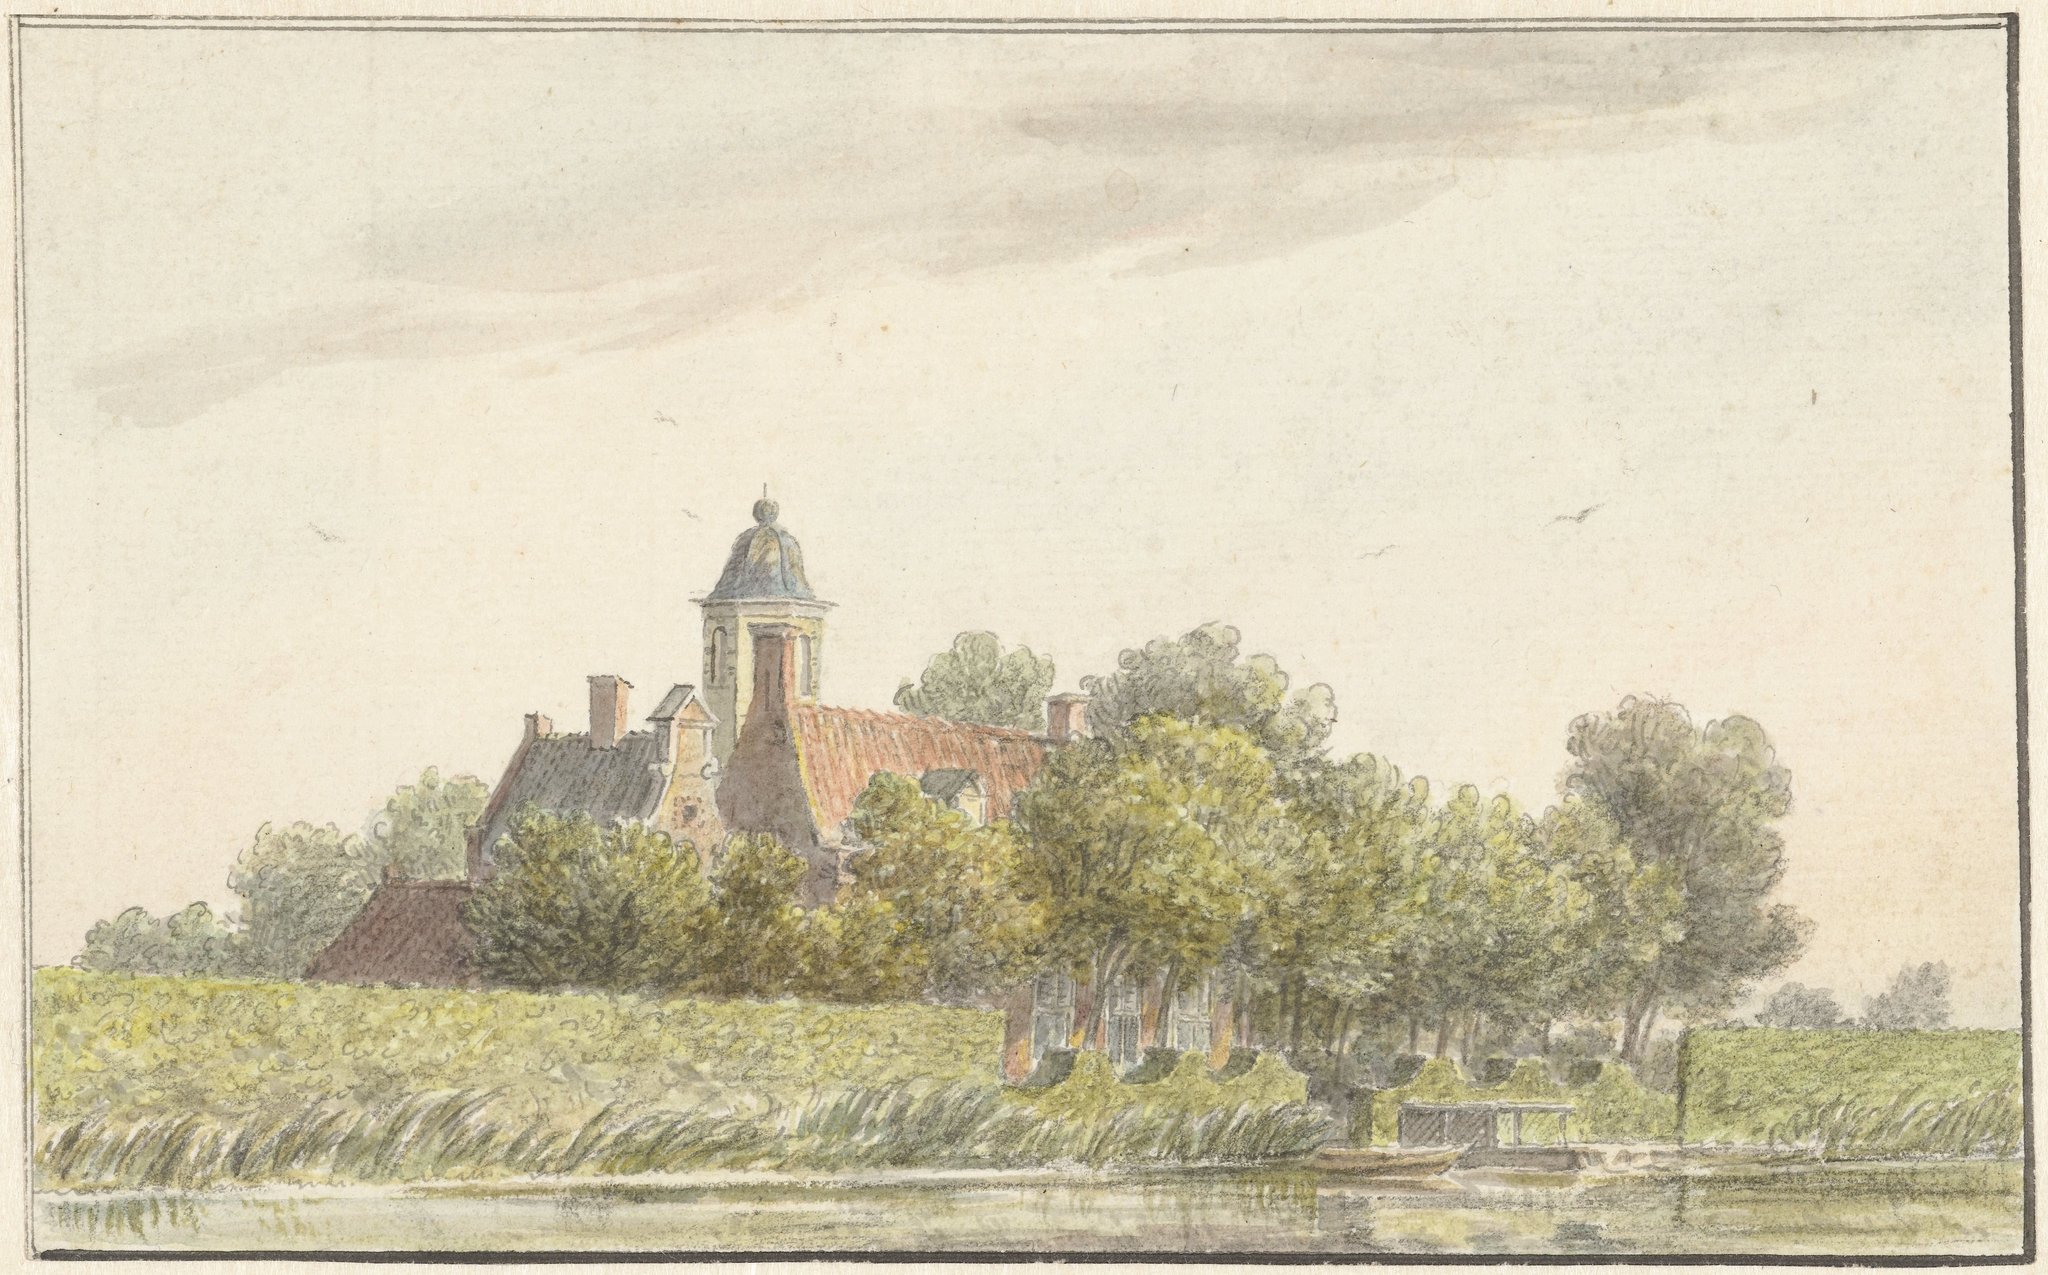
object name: drawing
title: Pauwentuin aan de Amstel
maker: martinus van der jagt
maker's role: draughtsman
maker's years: 1747-1805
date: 1757-1805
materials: chalk, ink, paper, watercolor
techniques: brush, pen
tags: rural housing, e.g. country-house, villa, cottage